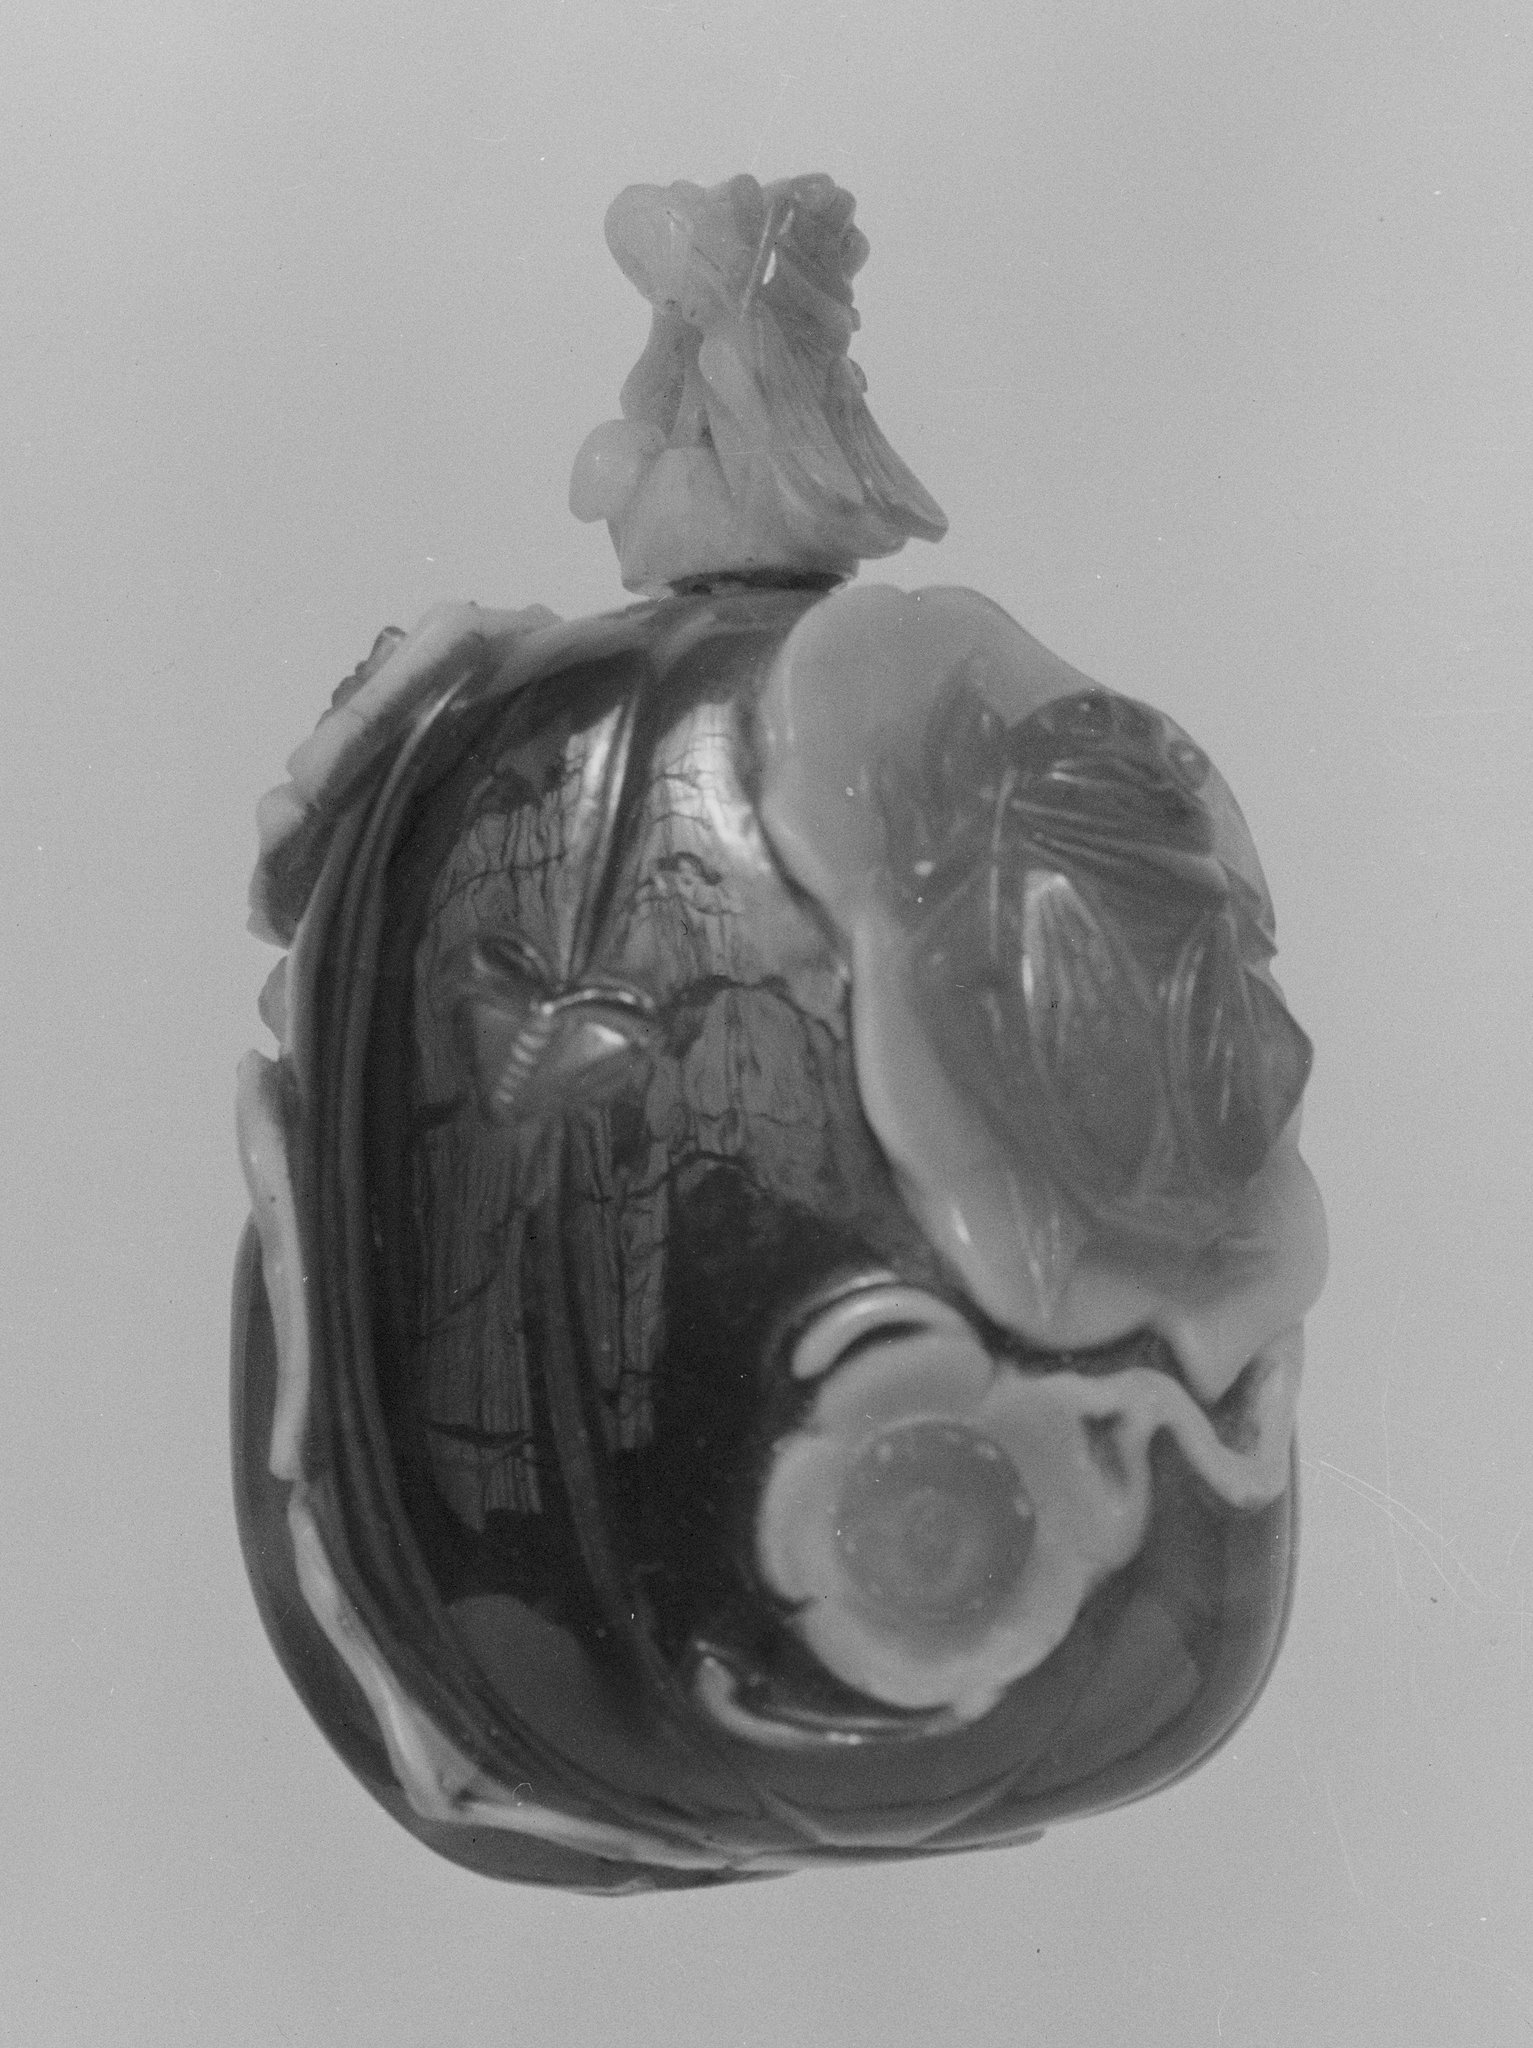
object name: snuff bottle with stopper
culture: chinese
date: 1701-1900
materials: stone, jade